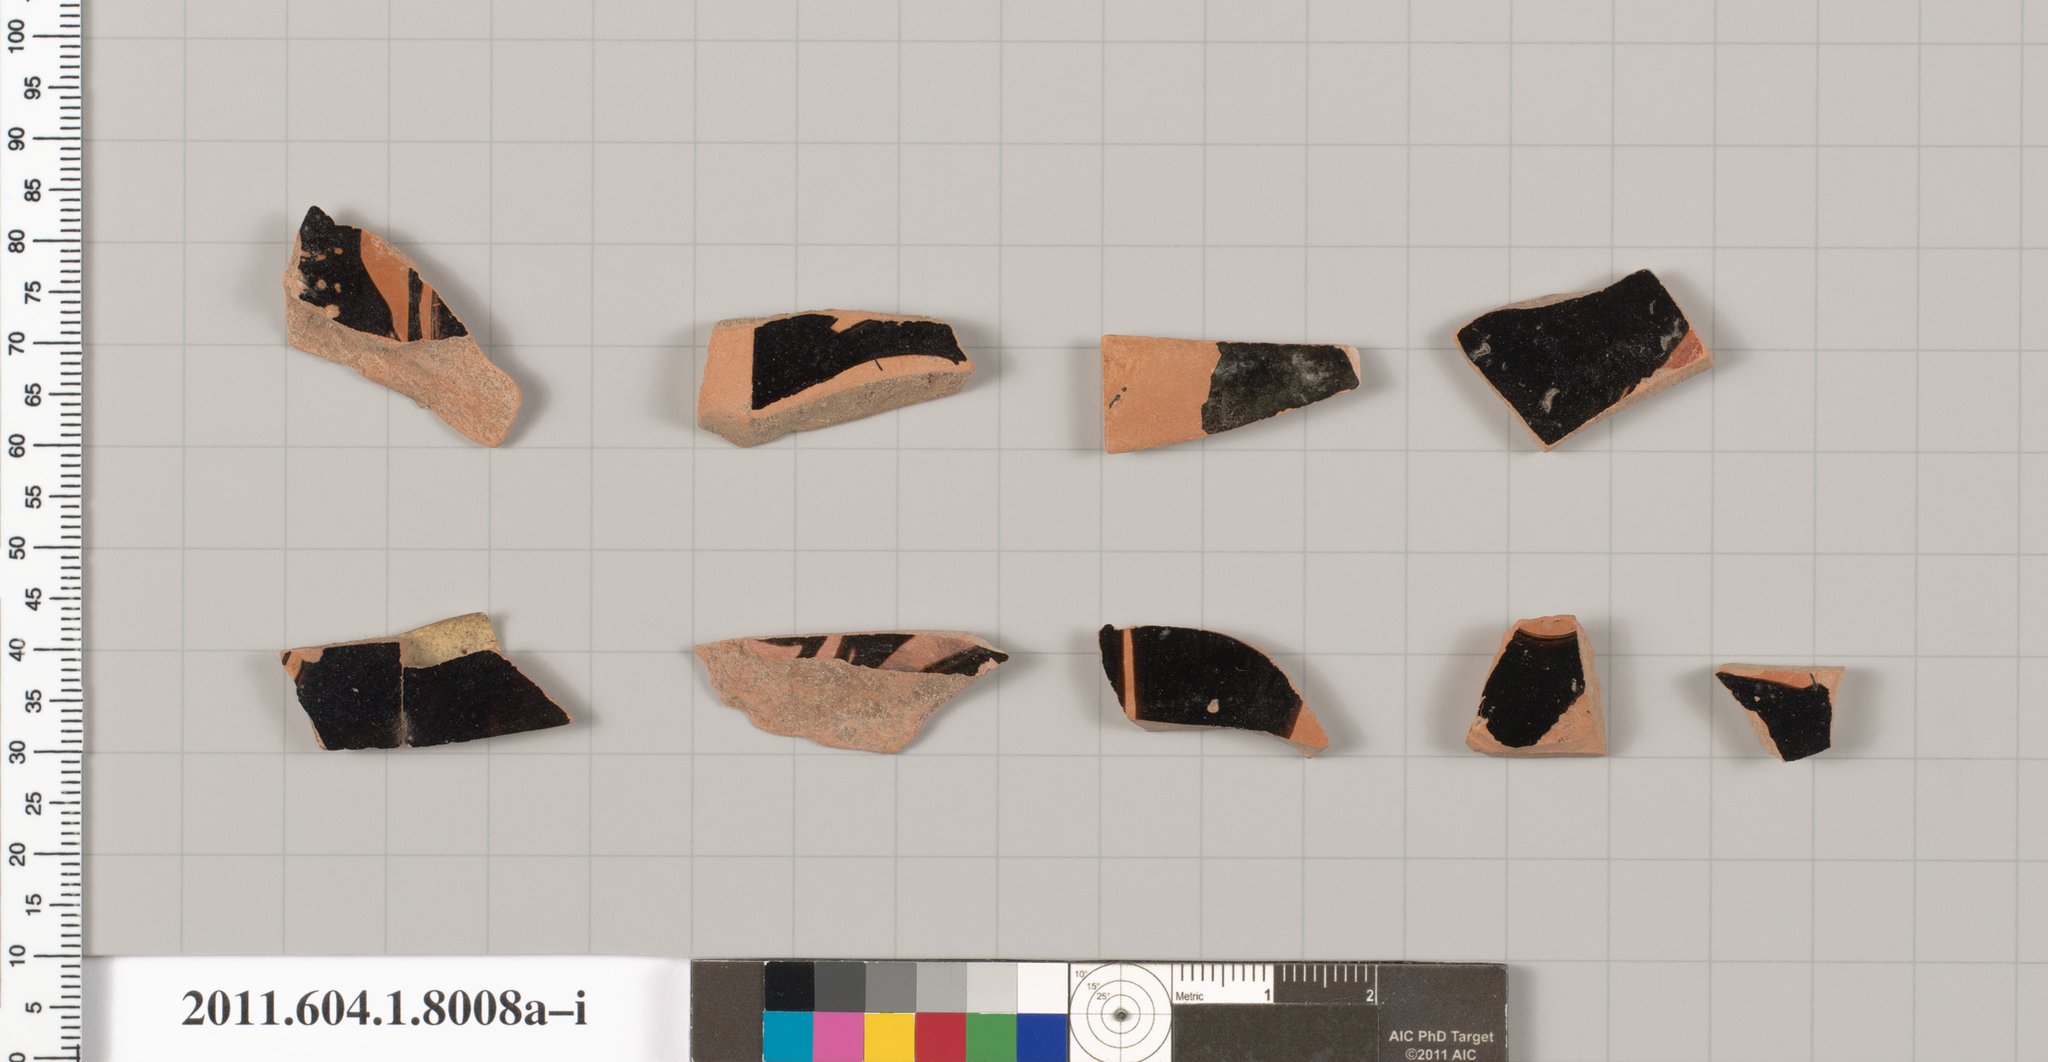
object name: kylix fragment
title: Terracotta fragments of kylikes (drinking cups)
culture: greek, attic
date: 460-450 BCE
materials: terracotta